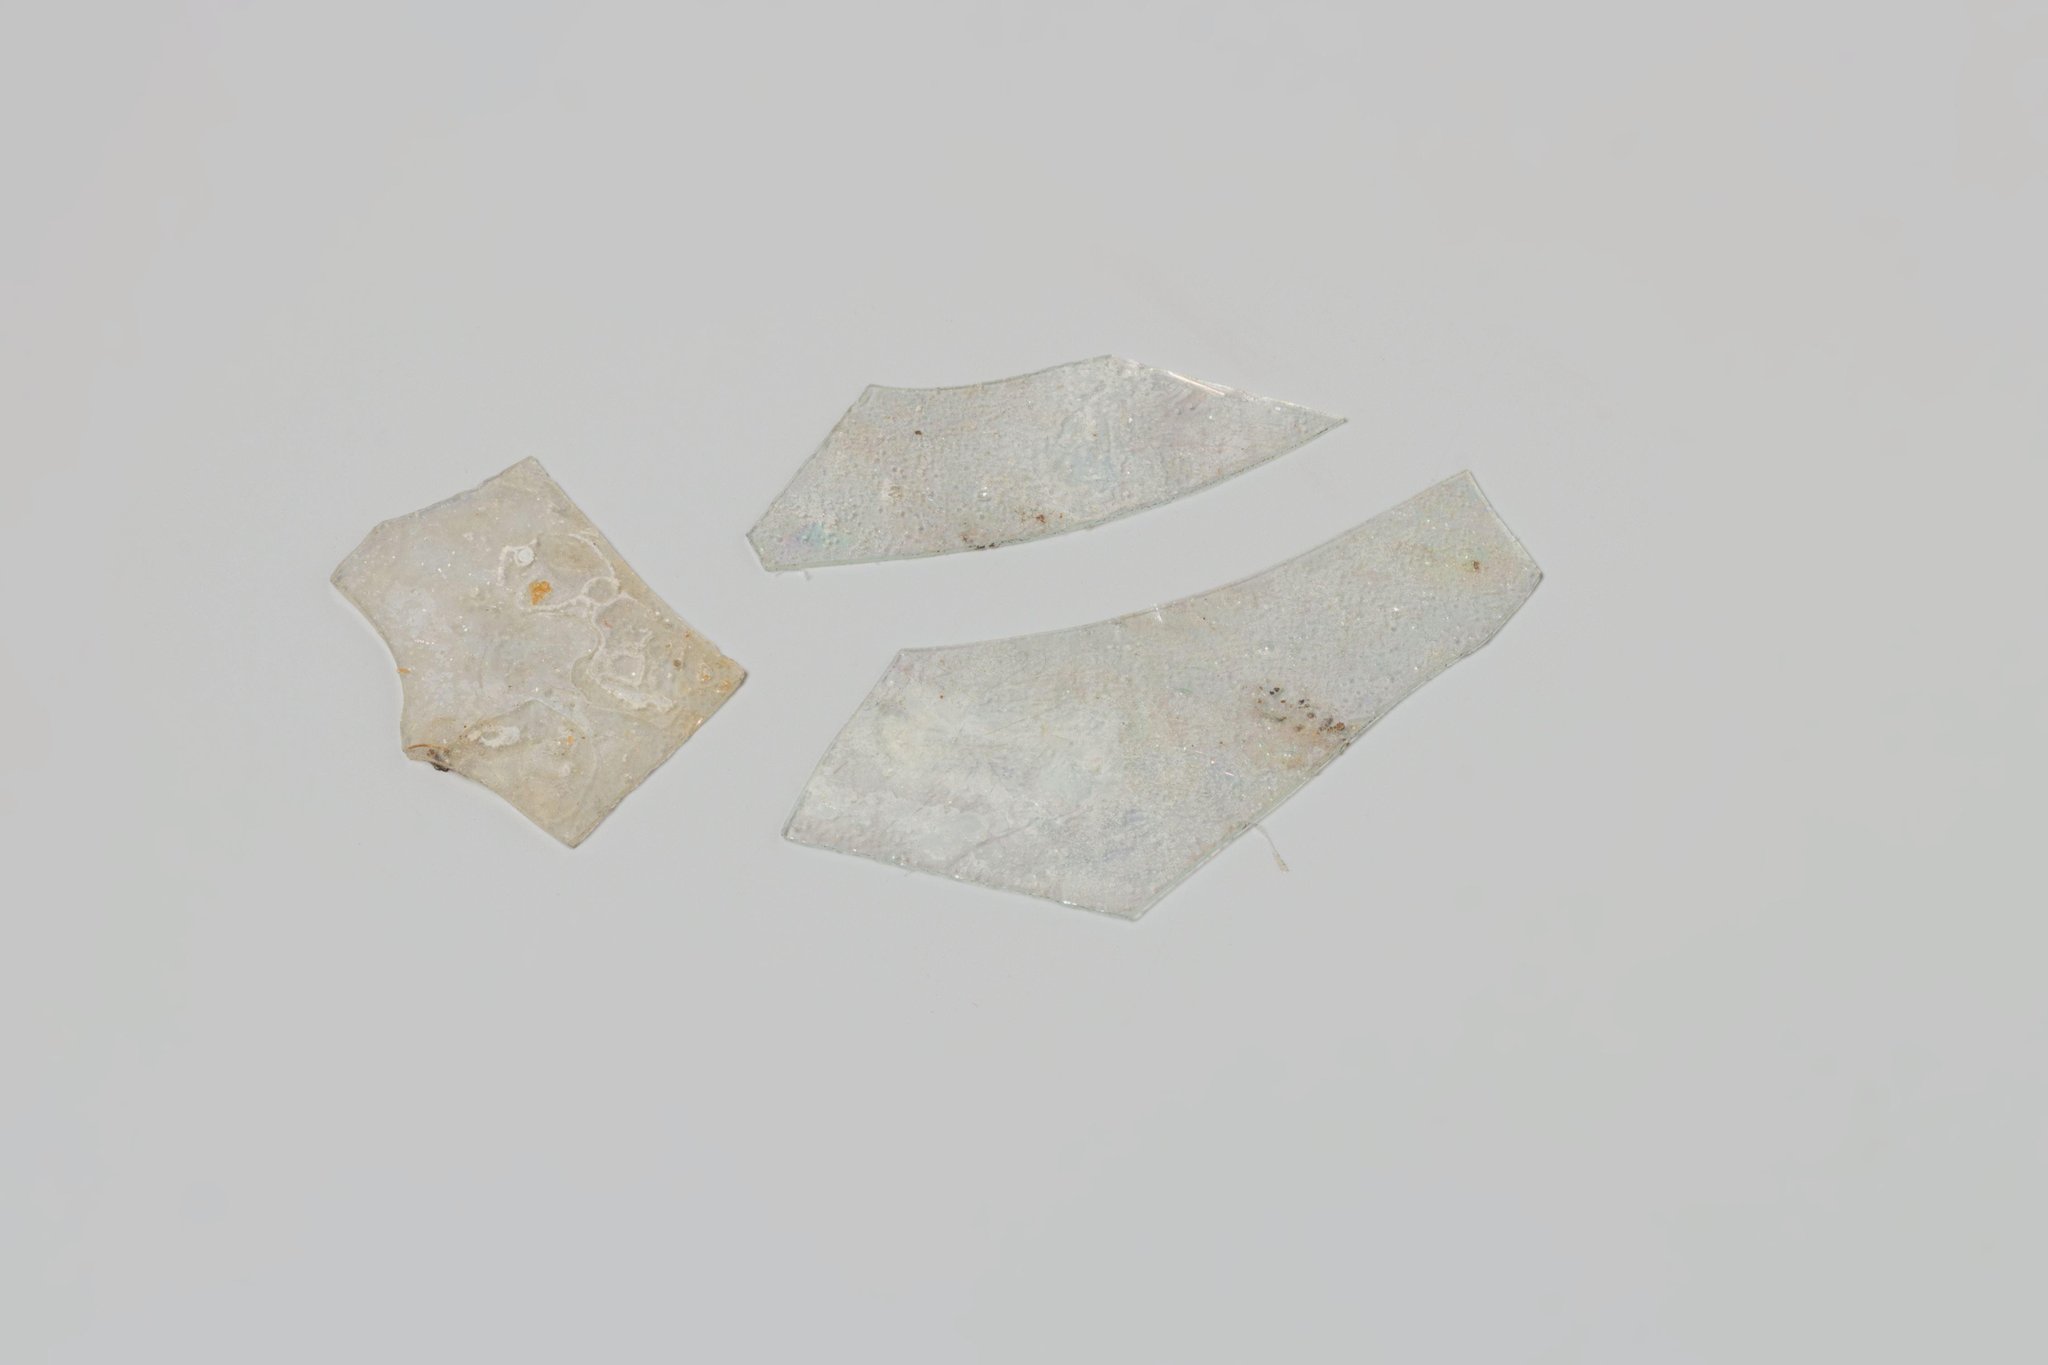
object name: case bottle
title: Glasscherven van een kelderfles uit het wrak van de in 1735 vergane Oost-Indiëvaarder 't Vliegend Hart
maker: Anonymous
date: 1700-1735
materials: glass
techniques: manufacturing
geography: middelburg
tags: 't vliegend hart (schip), verenigde oostindische compagnie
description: Kelderflessen zijn vierkant en werden gebruikt om o.a. jenever erin te bewaren.